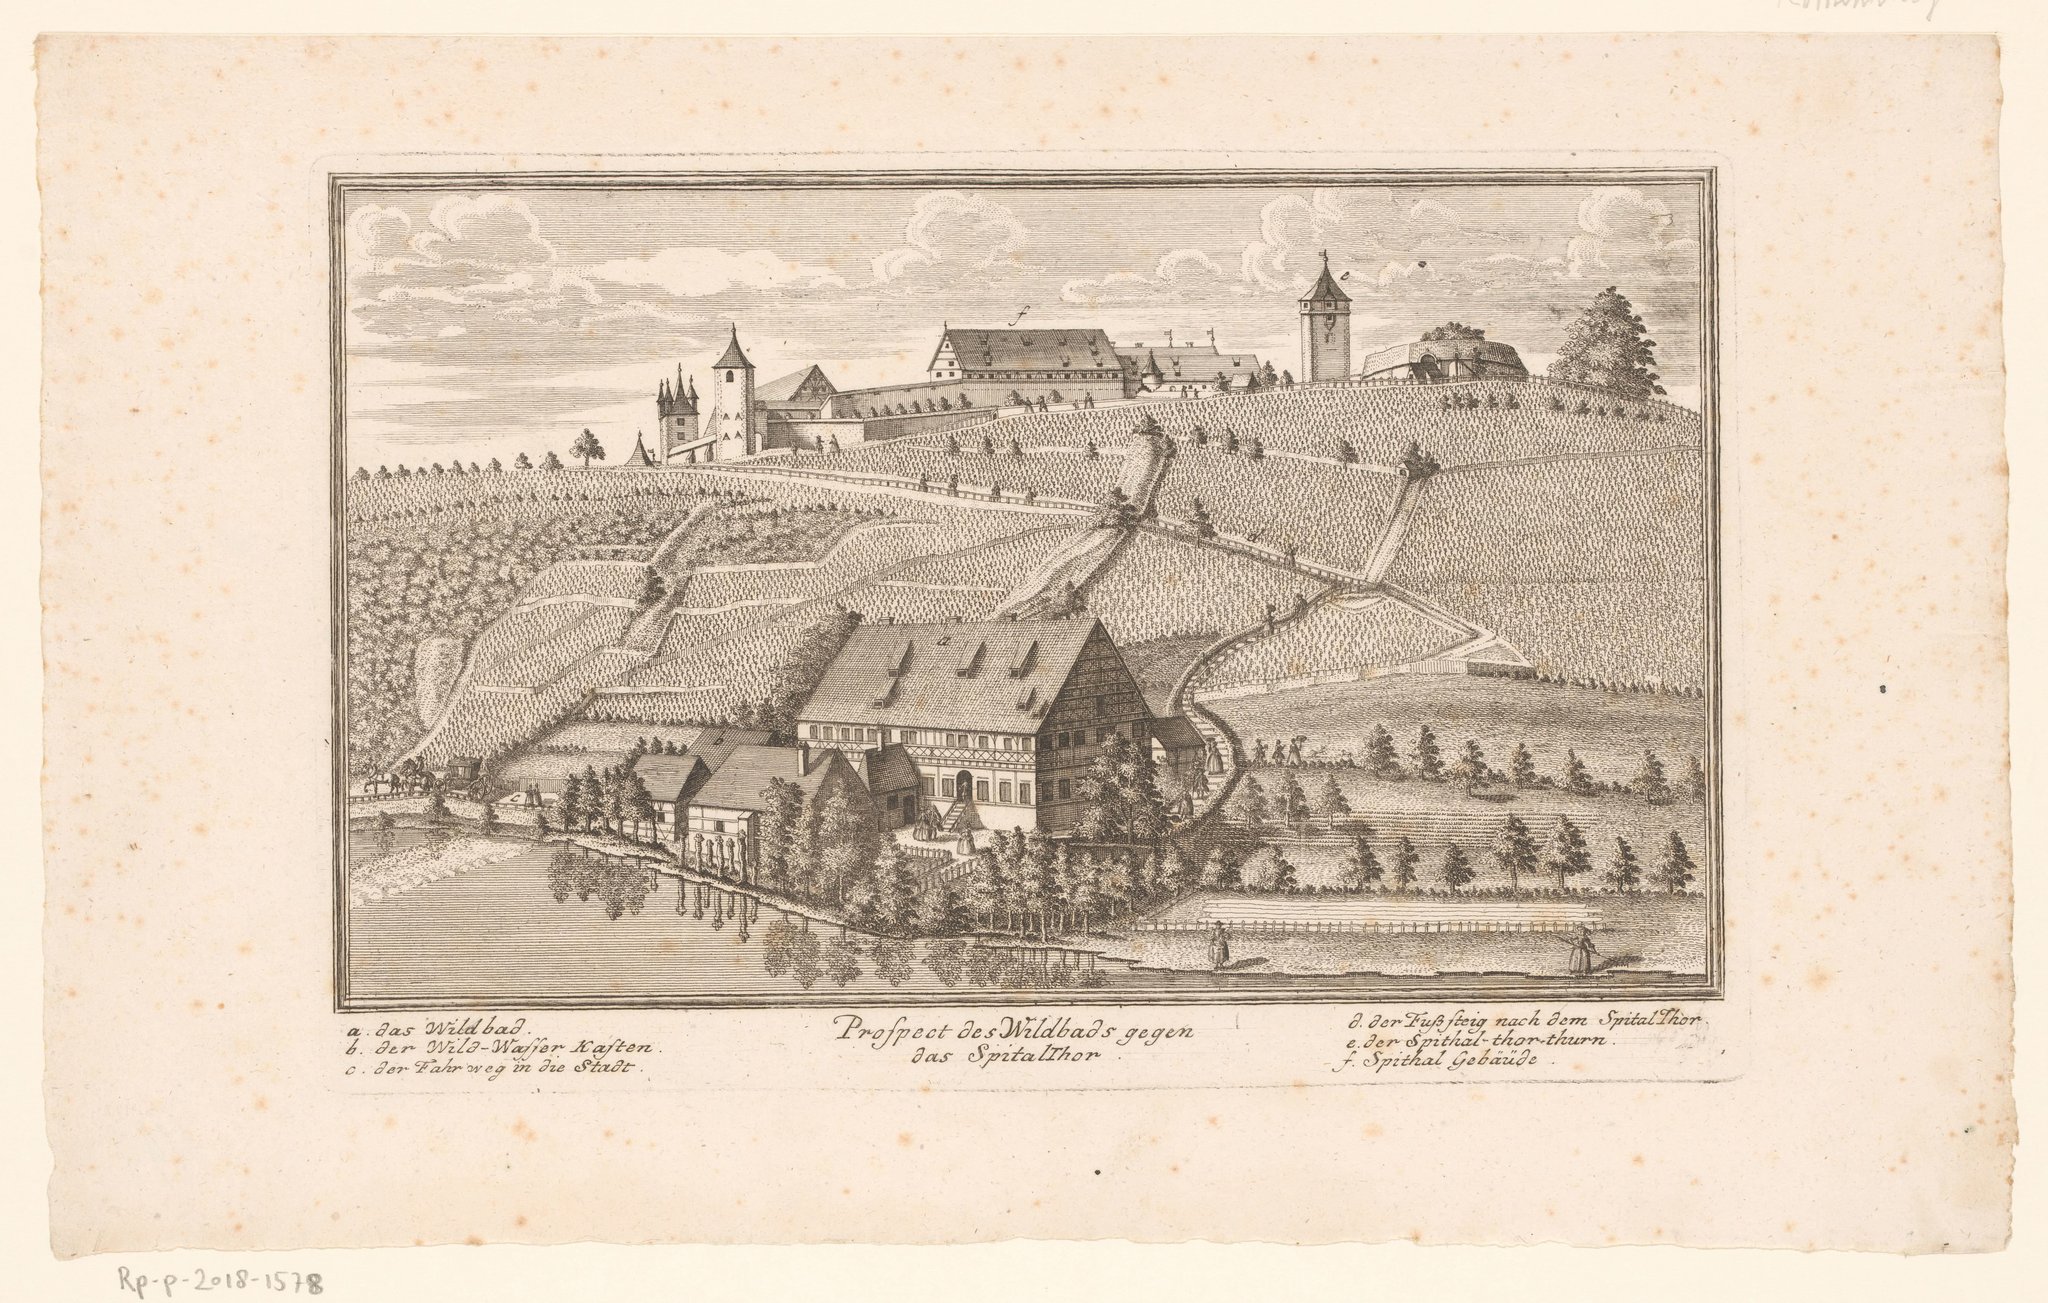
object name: print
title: Prospect des Wildbads gegen das Spitalthor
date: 1758-1796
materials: paper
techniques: engraving, etching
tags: hot spring, geyser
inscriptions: collector's mark: Lugt 2228